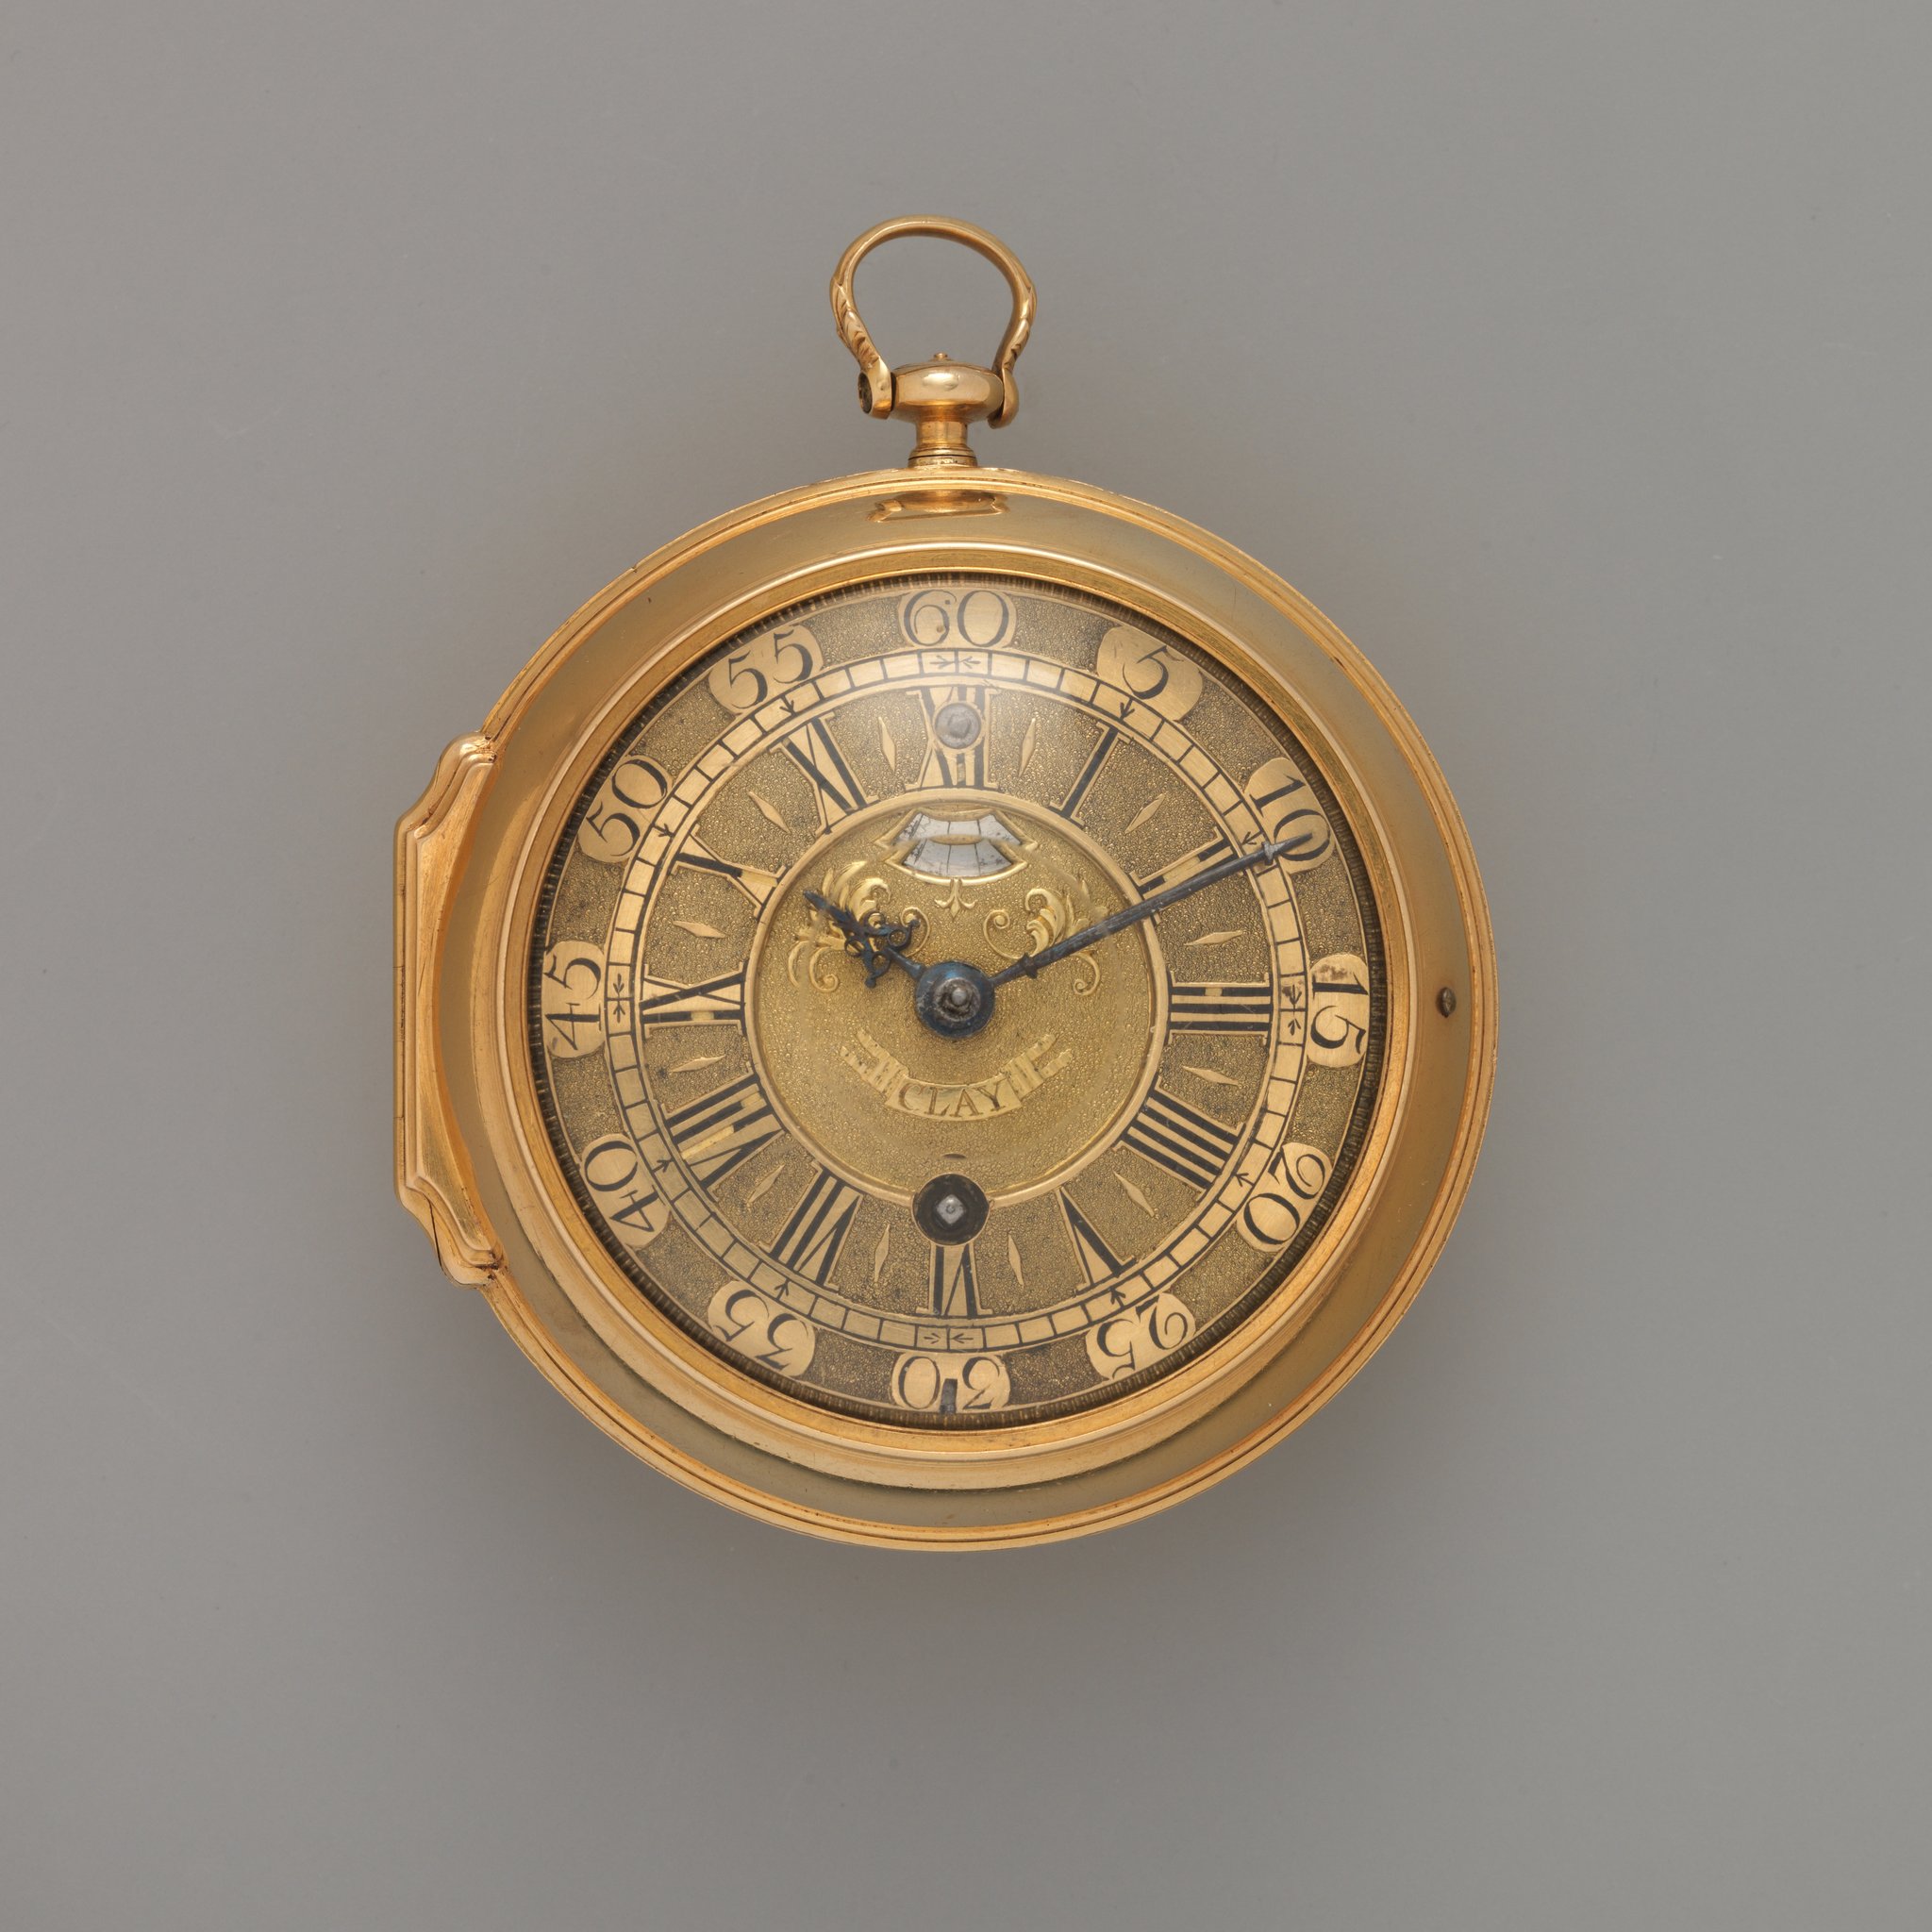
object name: watch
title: Watch with automaton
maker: charles clay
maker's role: maker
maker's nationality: british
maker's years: 1640-1740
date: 1720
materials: gold, silver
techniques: enamel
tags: male nudes,female nudes,trees